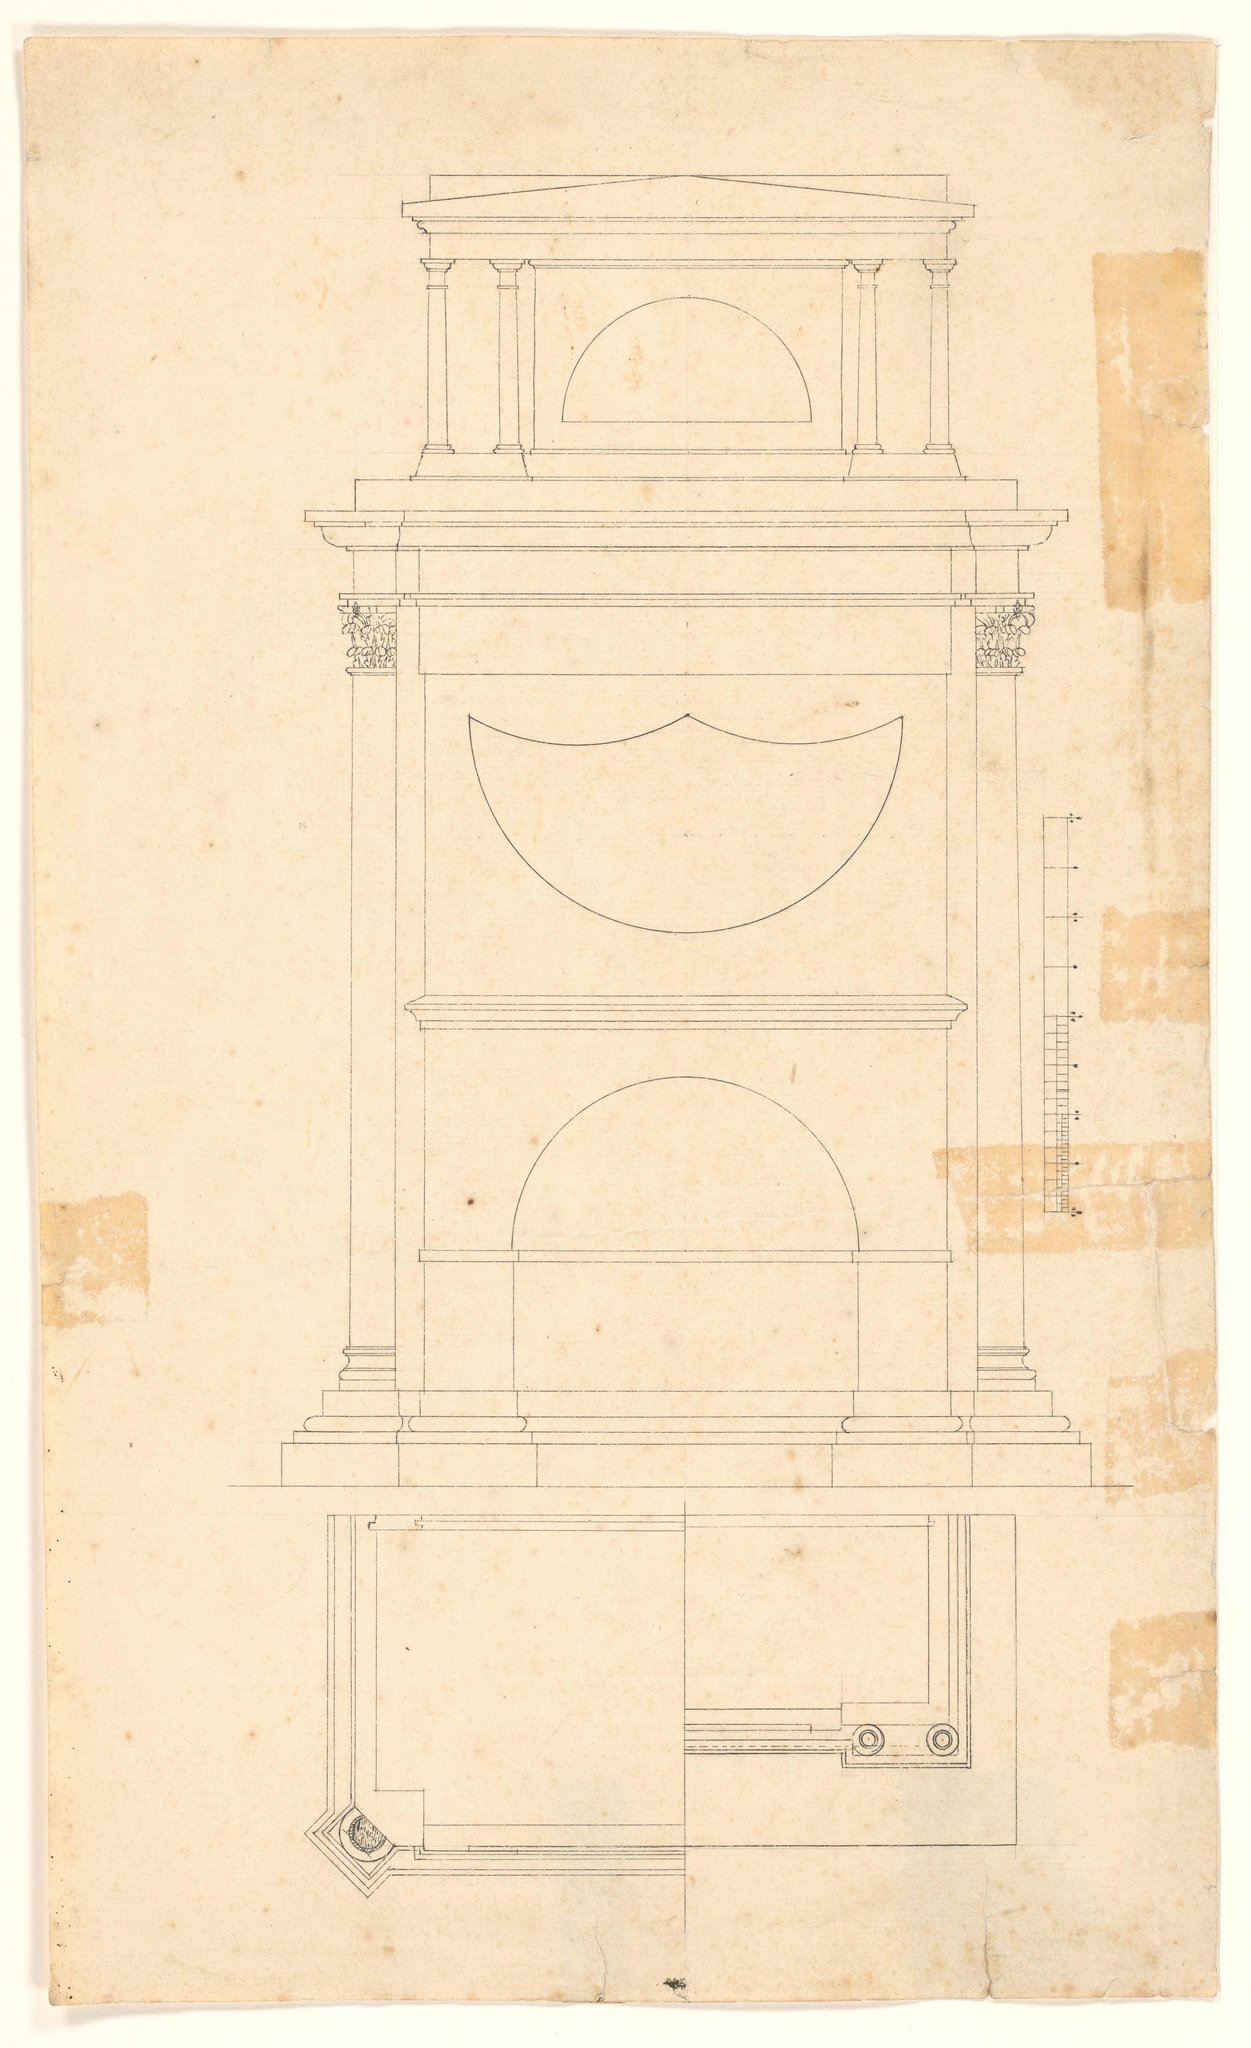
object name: design drawing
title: Ontwerp voor een secretaire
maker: carl wilhelm marckwort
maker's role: draughtsman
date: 1820-1823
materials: ink, paper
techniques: pen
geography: berlin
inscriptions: watermark: ‘VI’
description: Verdiepte velden, met daaronder een in tweeën gedeelde plattegrond.